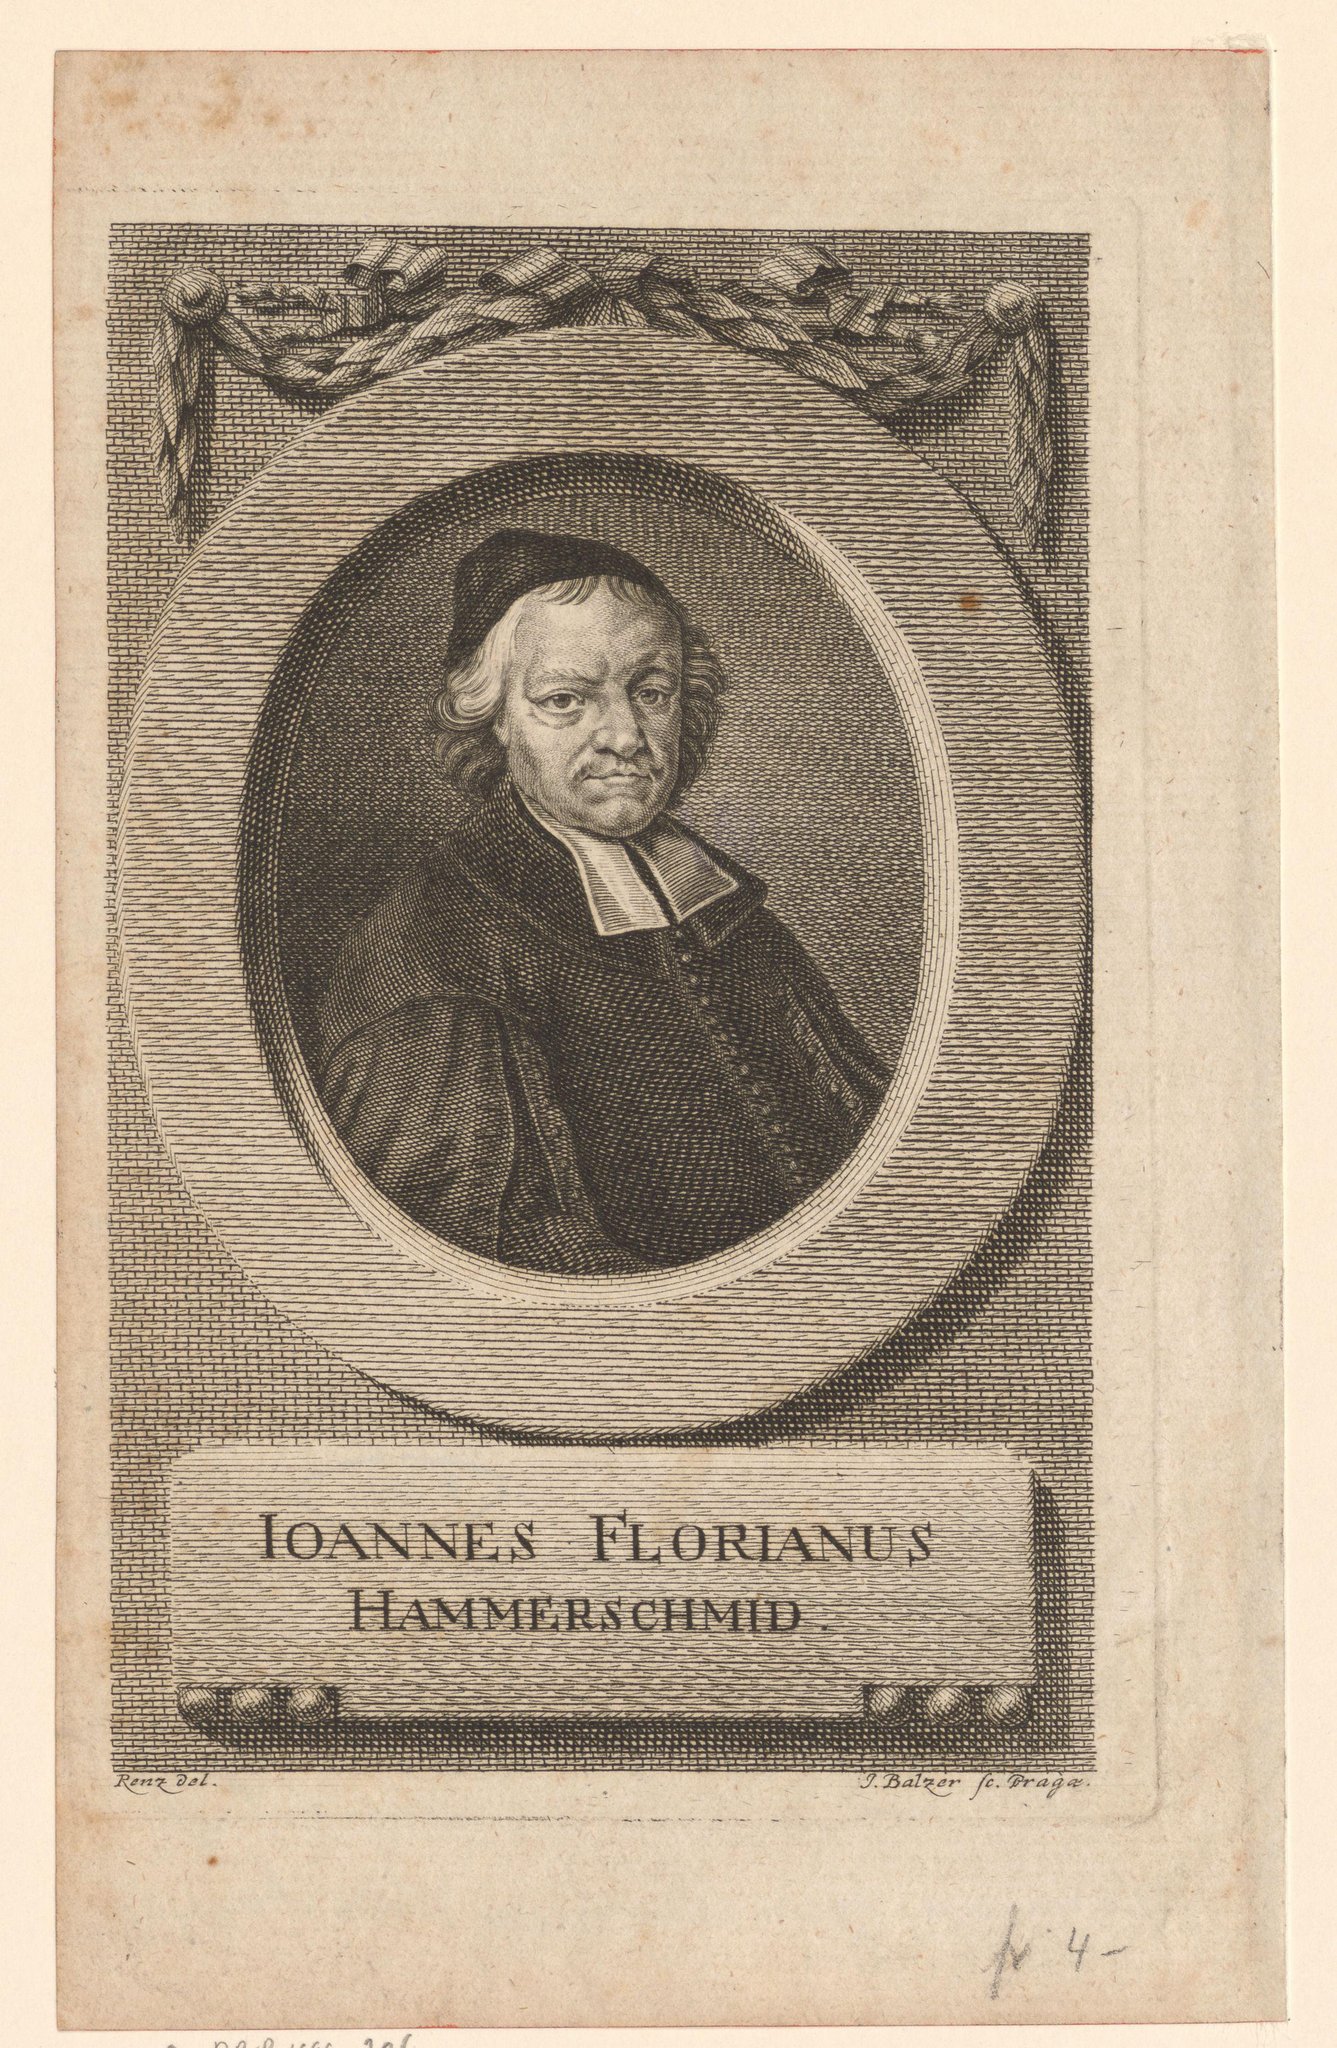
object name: print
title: Portret van Johann Florian Hammerschmid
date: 1746-1799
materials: paper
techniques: engraving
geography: prague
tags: prague, theologian, historical persons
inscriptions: collector's mark: Lugt 2228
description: Prent mogelijk uit: Effigies Virorum eruditorum atque Artificum Bohemiae et Moraviae (...). Praag: Wolfgang Gerle, 1775, dl. 2.